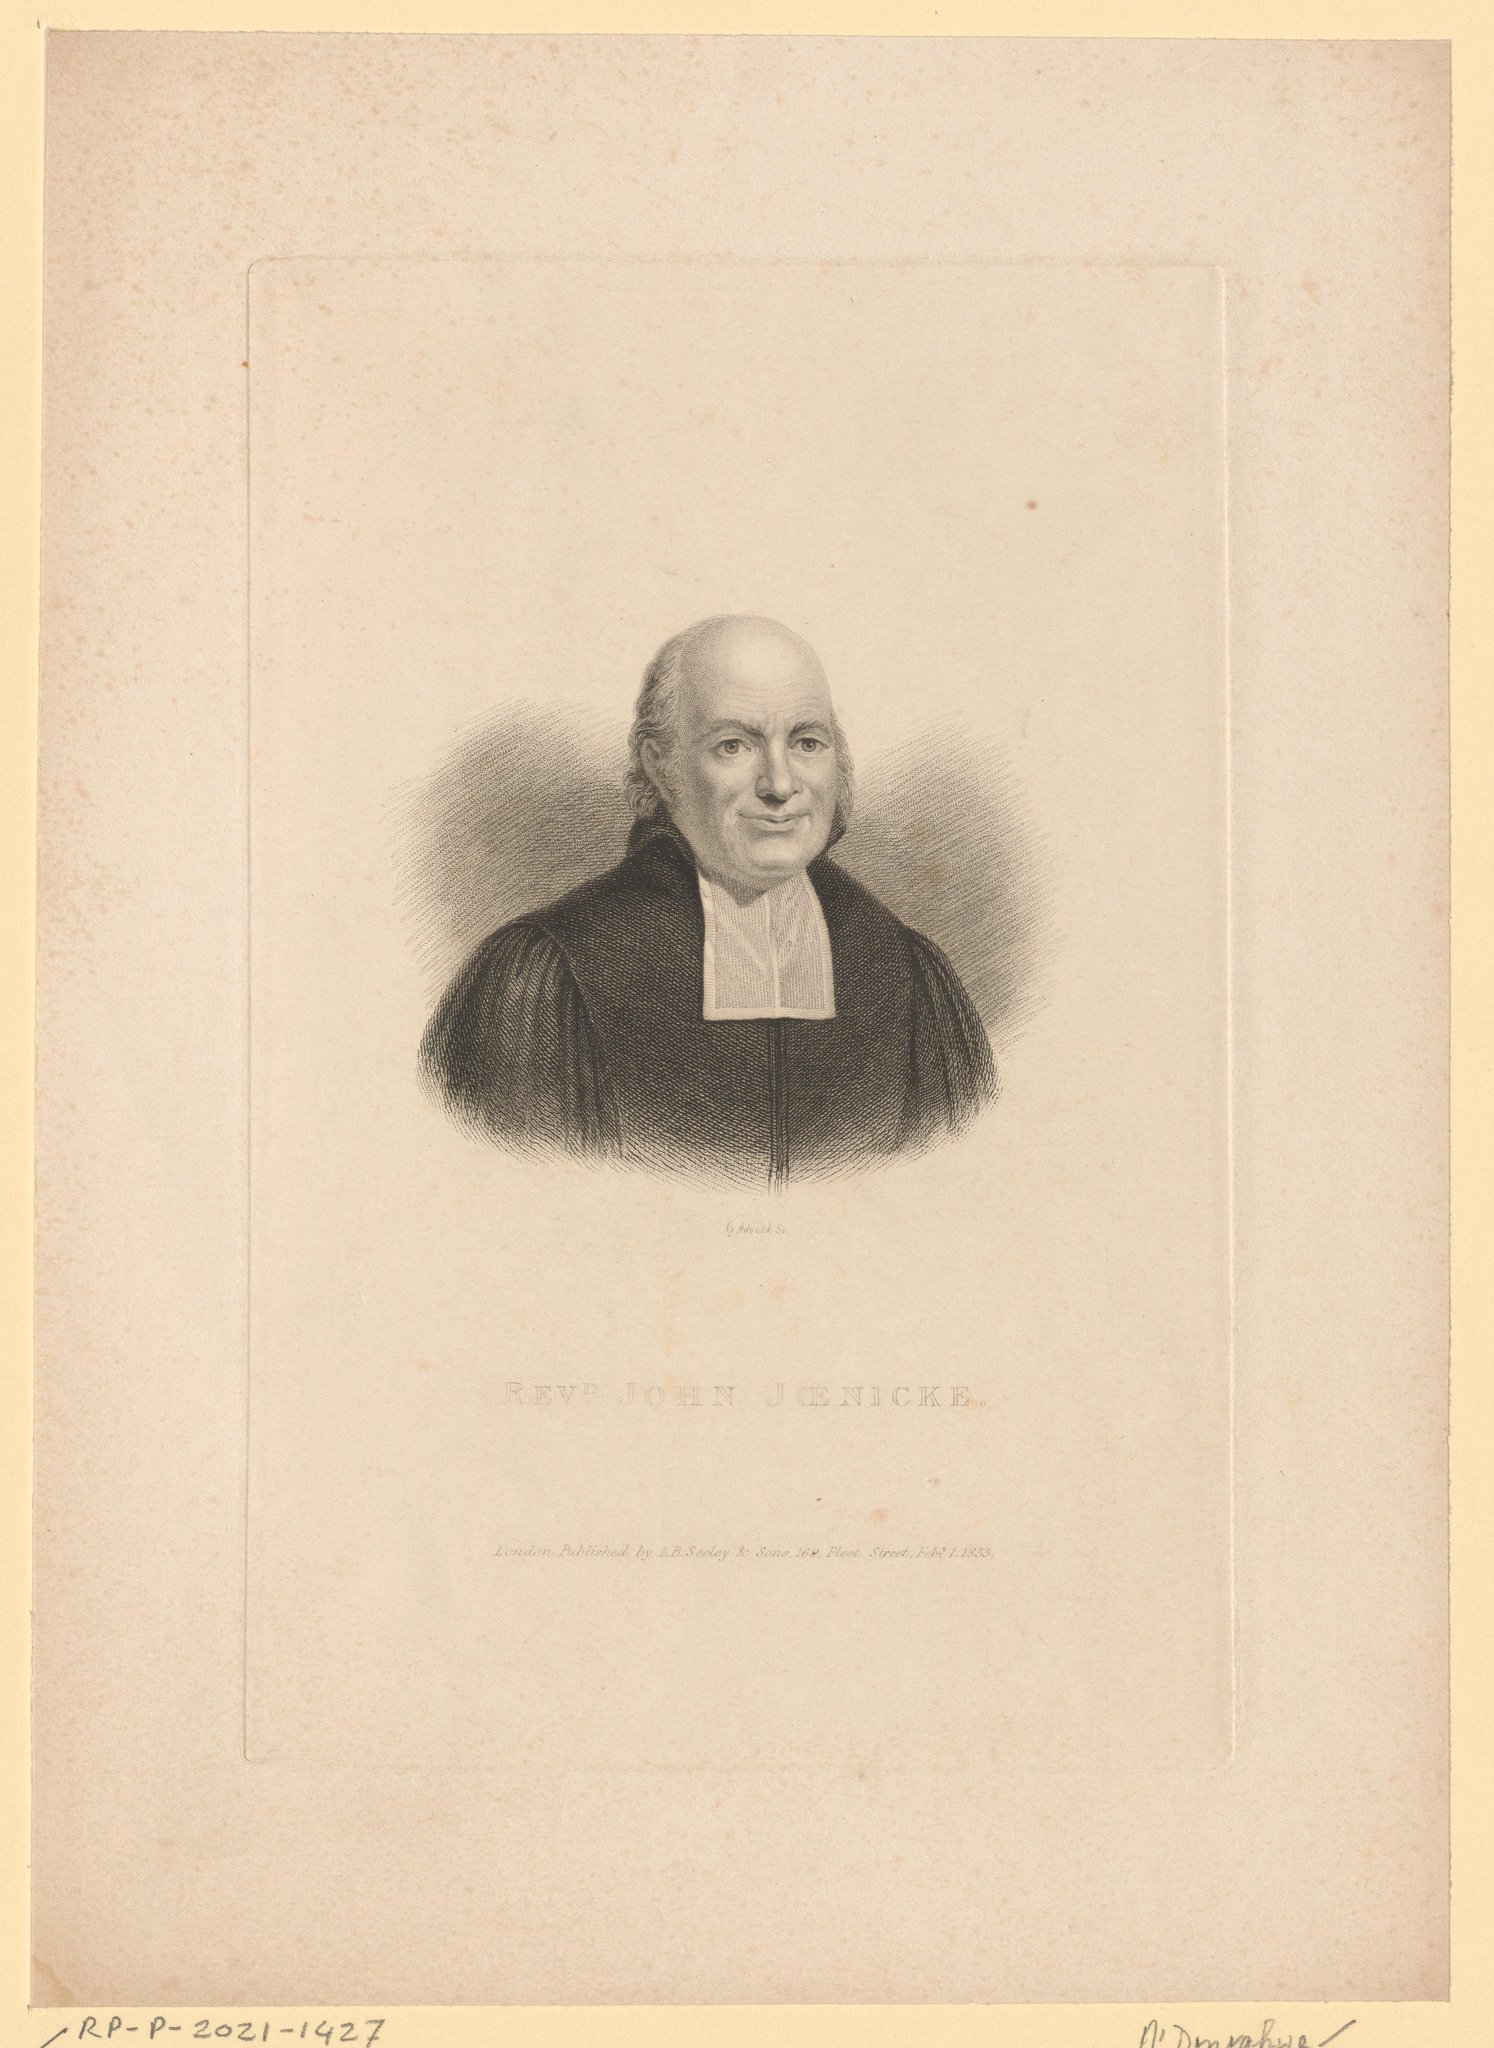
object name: print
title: Portret van Johannes Jaenicke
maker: george henry adcock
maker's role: print maker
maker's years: 1803-1851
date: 1833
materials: paper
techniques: etching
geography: london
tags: historical persons, functionaries and dignitaries ~ protestant churches